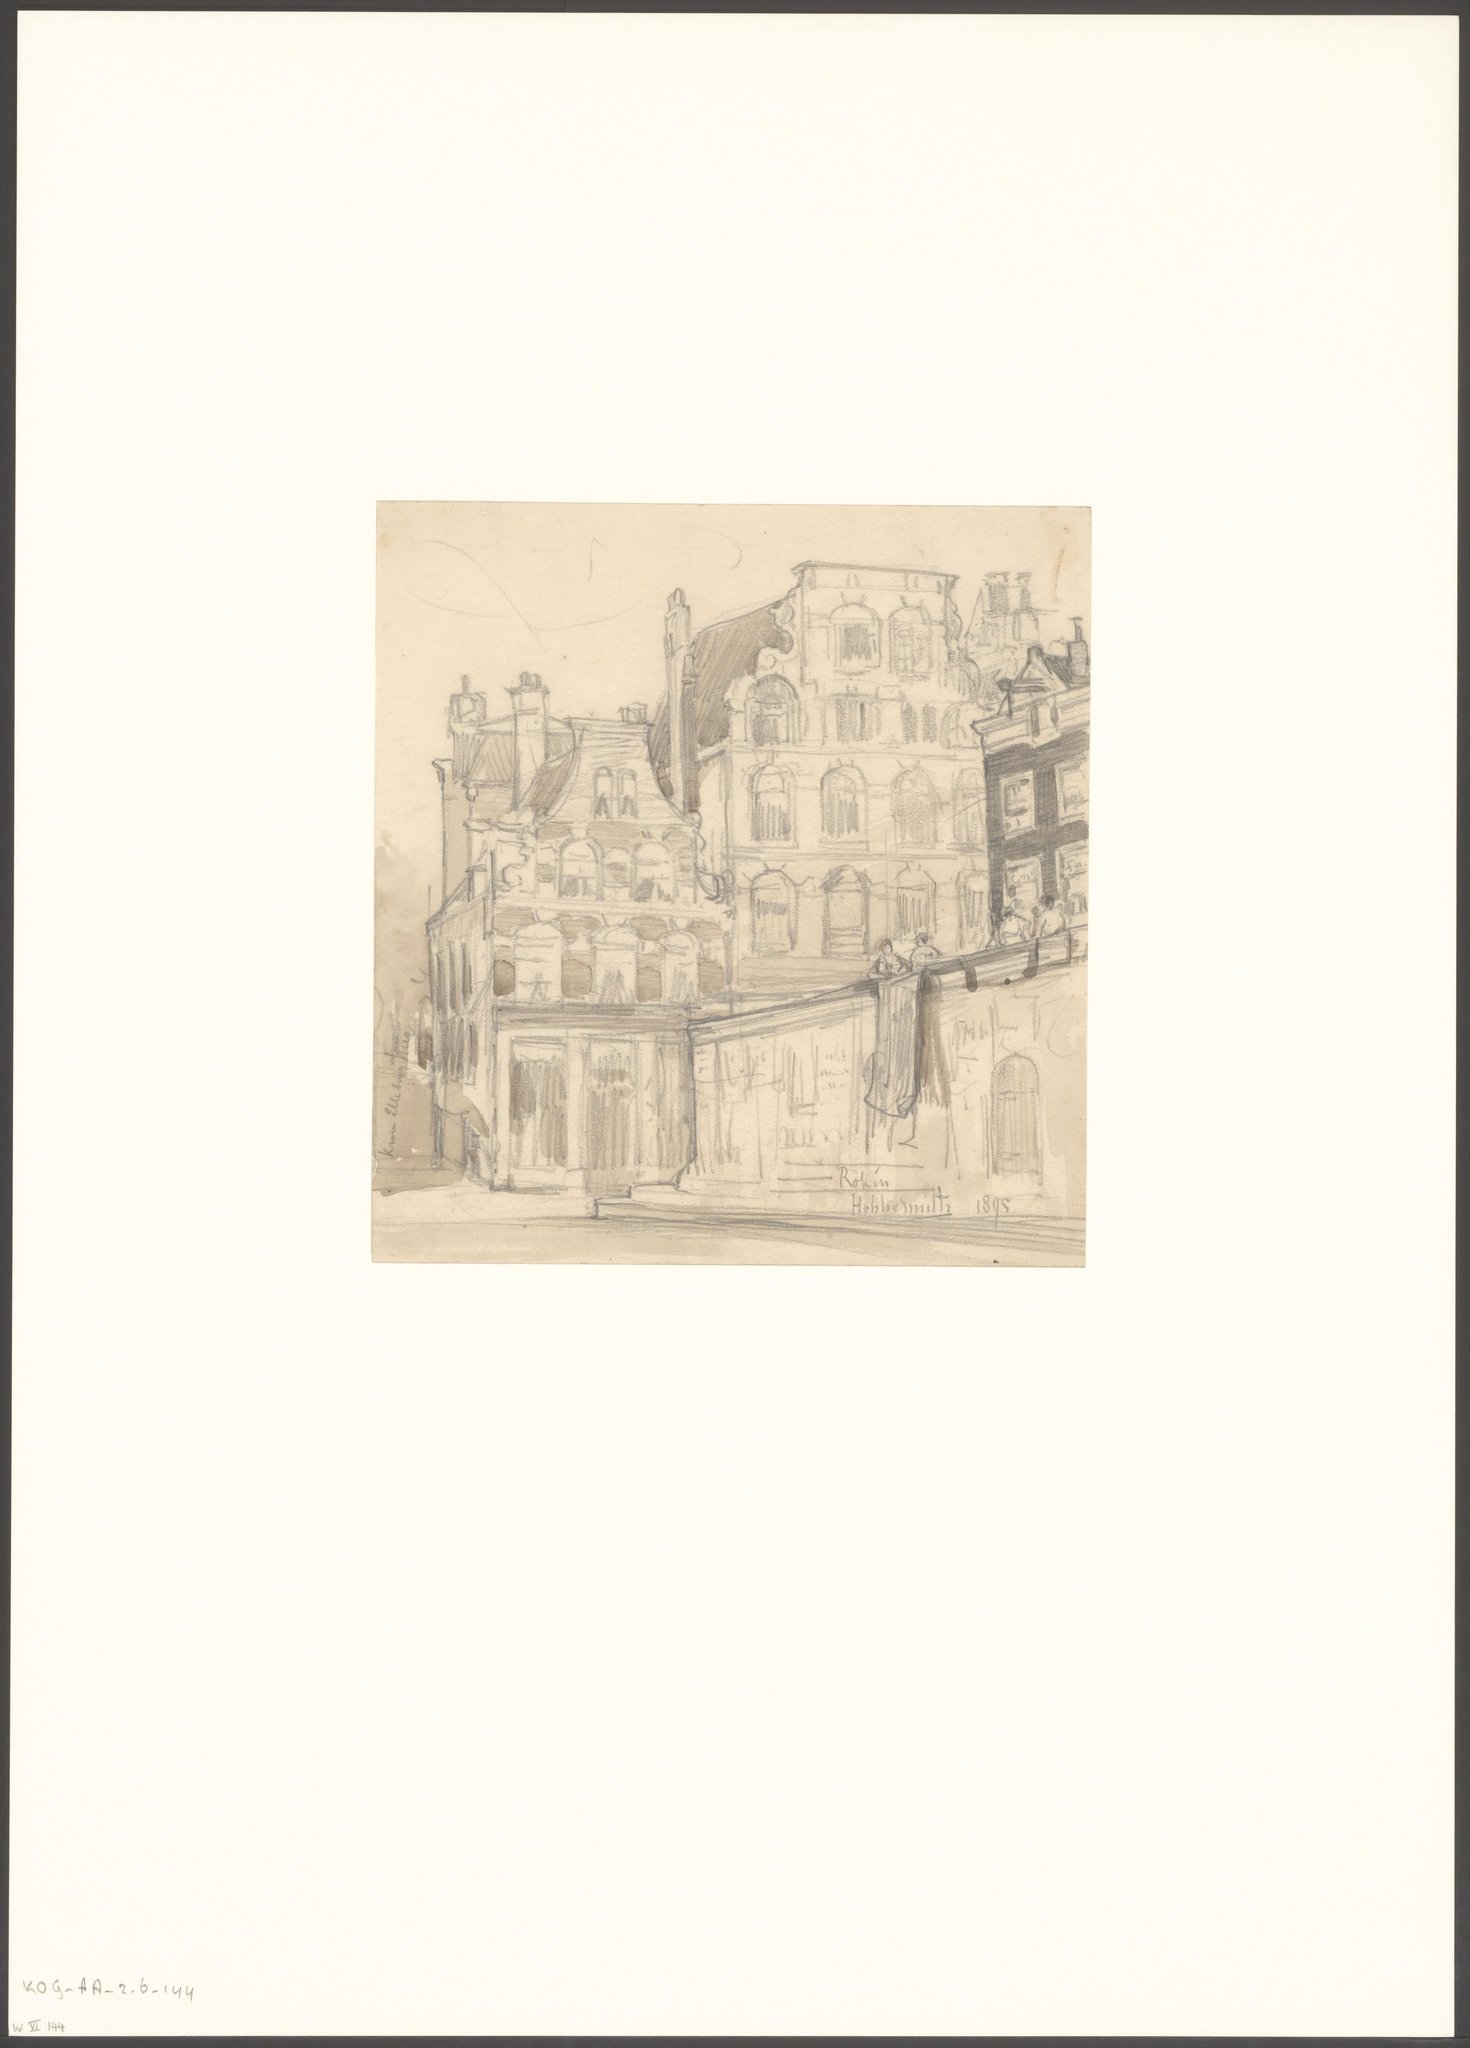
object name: drawing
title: Gezicht op het Rokin, hoek Kromme Elleboogsteeg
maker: hobbe smith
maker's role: painter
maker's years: 1862-1942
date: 1895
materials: ink, paper, pencil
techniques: brush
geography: amsterdam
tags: city-view in general; 'veduta', façade (of house or building), street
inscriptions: collector's mark: Lugt 800a, signature and date: ‘Hobbe Smith 1895’, inscription: ‘Krom Elleboog steeg / Rokin’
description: Tekening binnen de Atlas Van Eck ingedeeld op wijknummer 6.